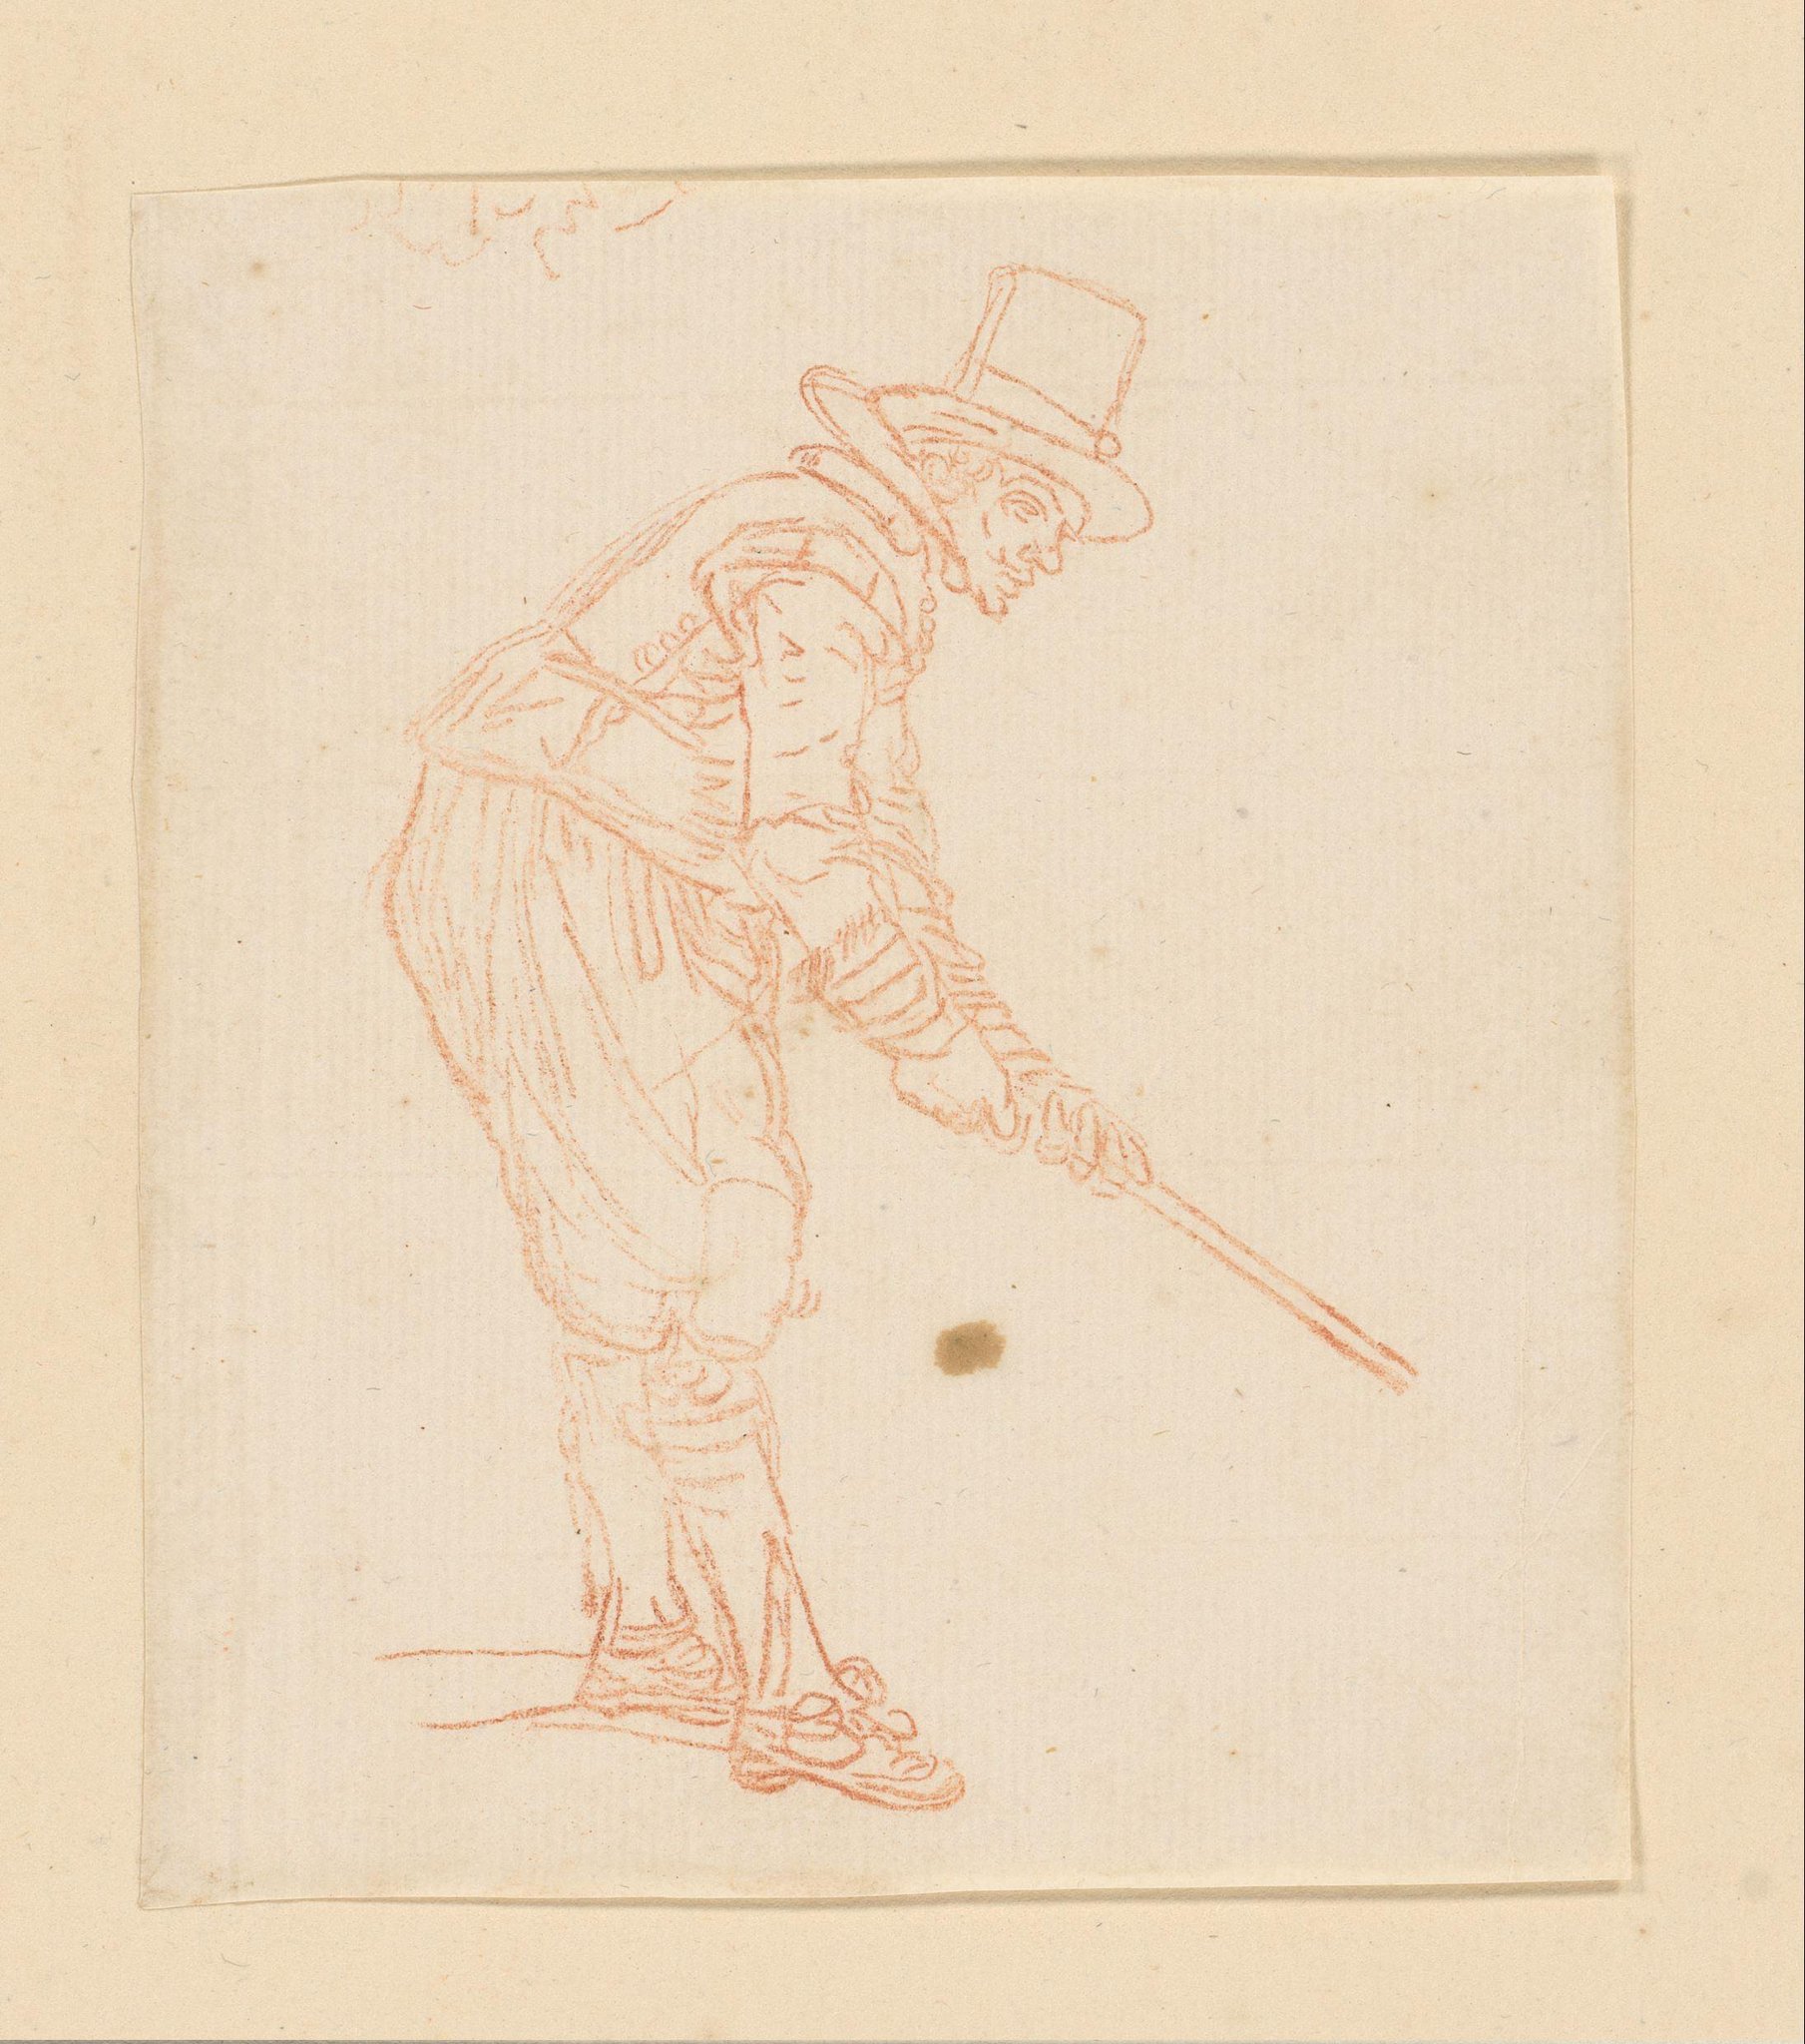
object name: drawing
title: Kolfspeler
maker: cornelis ploos van amstel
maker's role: draughtsman, print maker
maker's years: 1726-1798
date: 1758-1762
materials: chalk, paper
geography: amsterdam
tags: 'kolf' (ball game) (+ sportsman, player, etc.)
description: Over de doordruktekeningen van Ploos van Amstel zie LNP, p. 201.